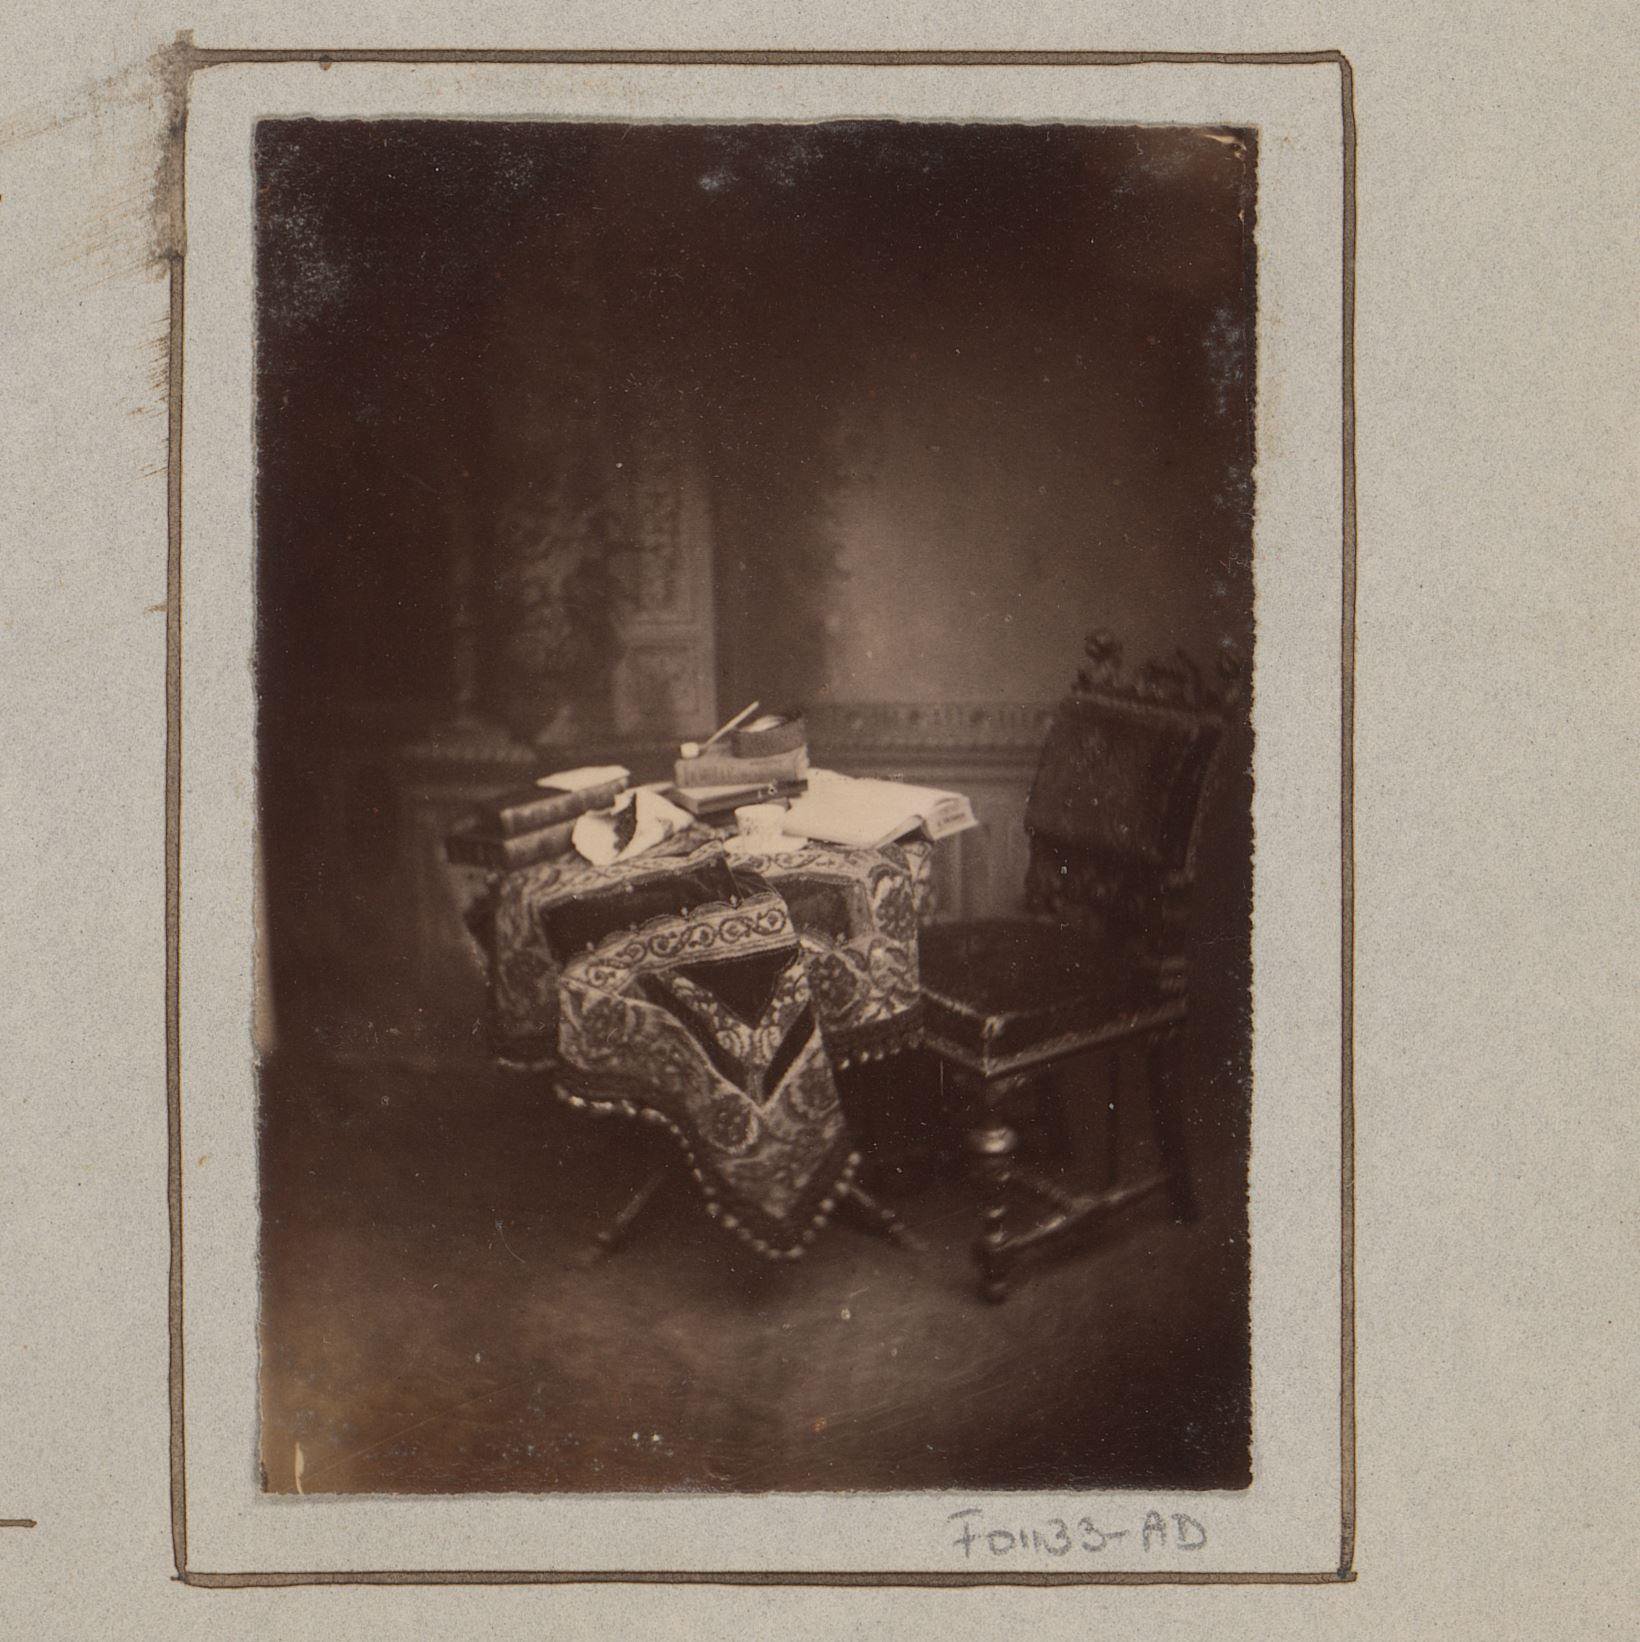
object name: album leaf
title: Stilleven van een stoel en tafel met boeken en een pijp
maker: marinus pieter filbri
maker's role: instrument maker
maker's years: 1852-1917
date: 1887-1888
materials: paper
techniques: albumen print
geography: netherlands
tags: table, still life of related objects, chair, netherlands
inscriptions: inscription: ‘Stilleven. (plaque au gel.brom-d'arg/ par E. Beernart/ 10. sec.’